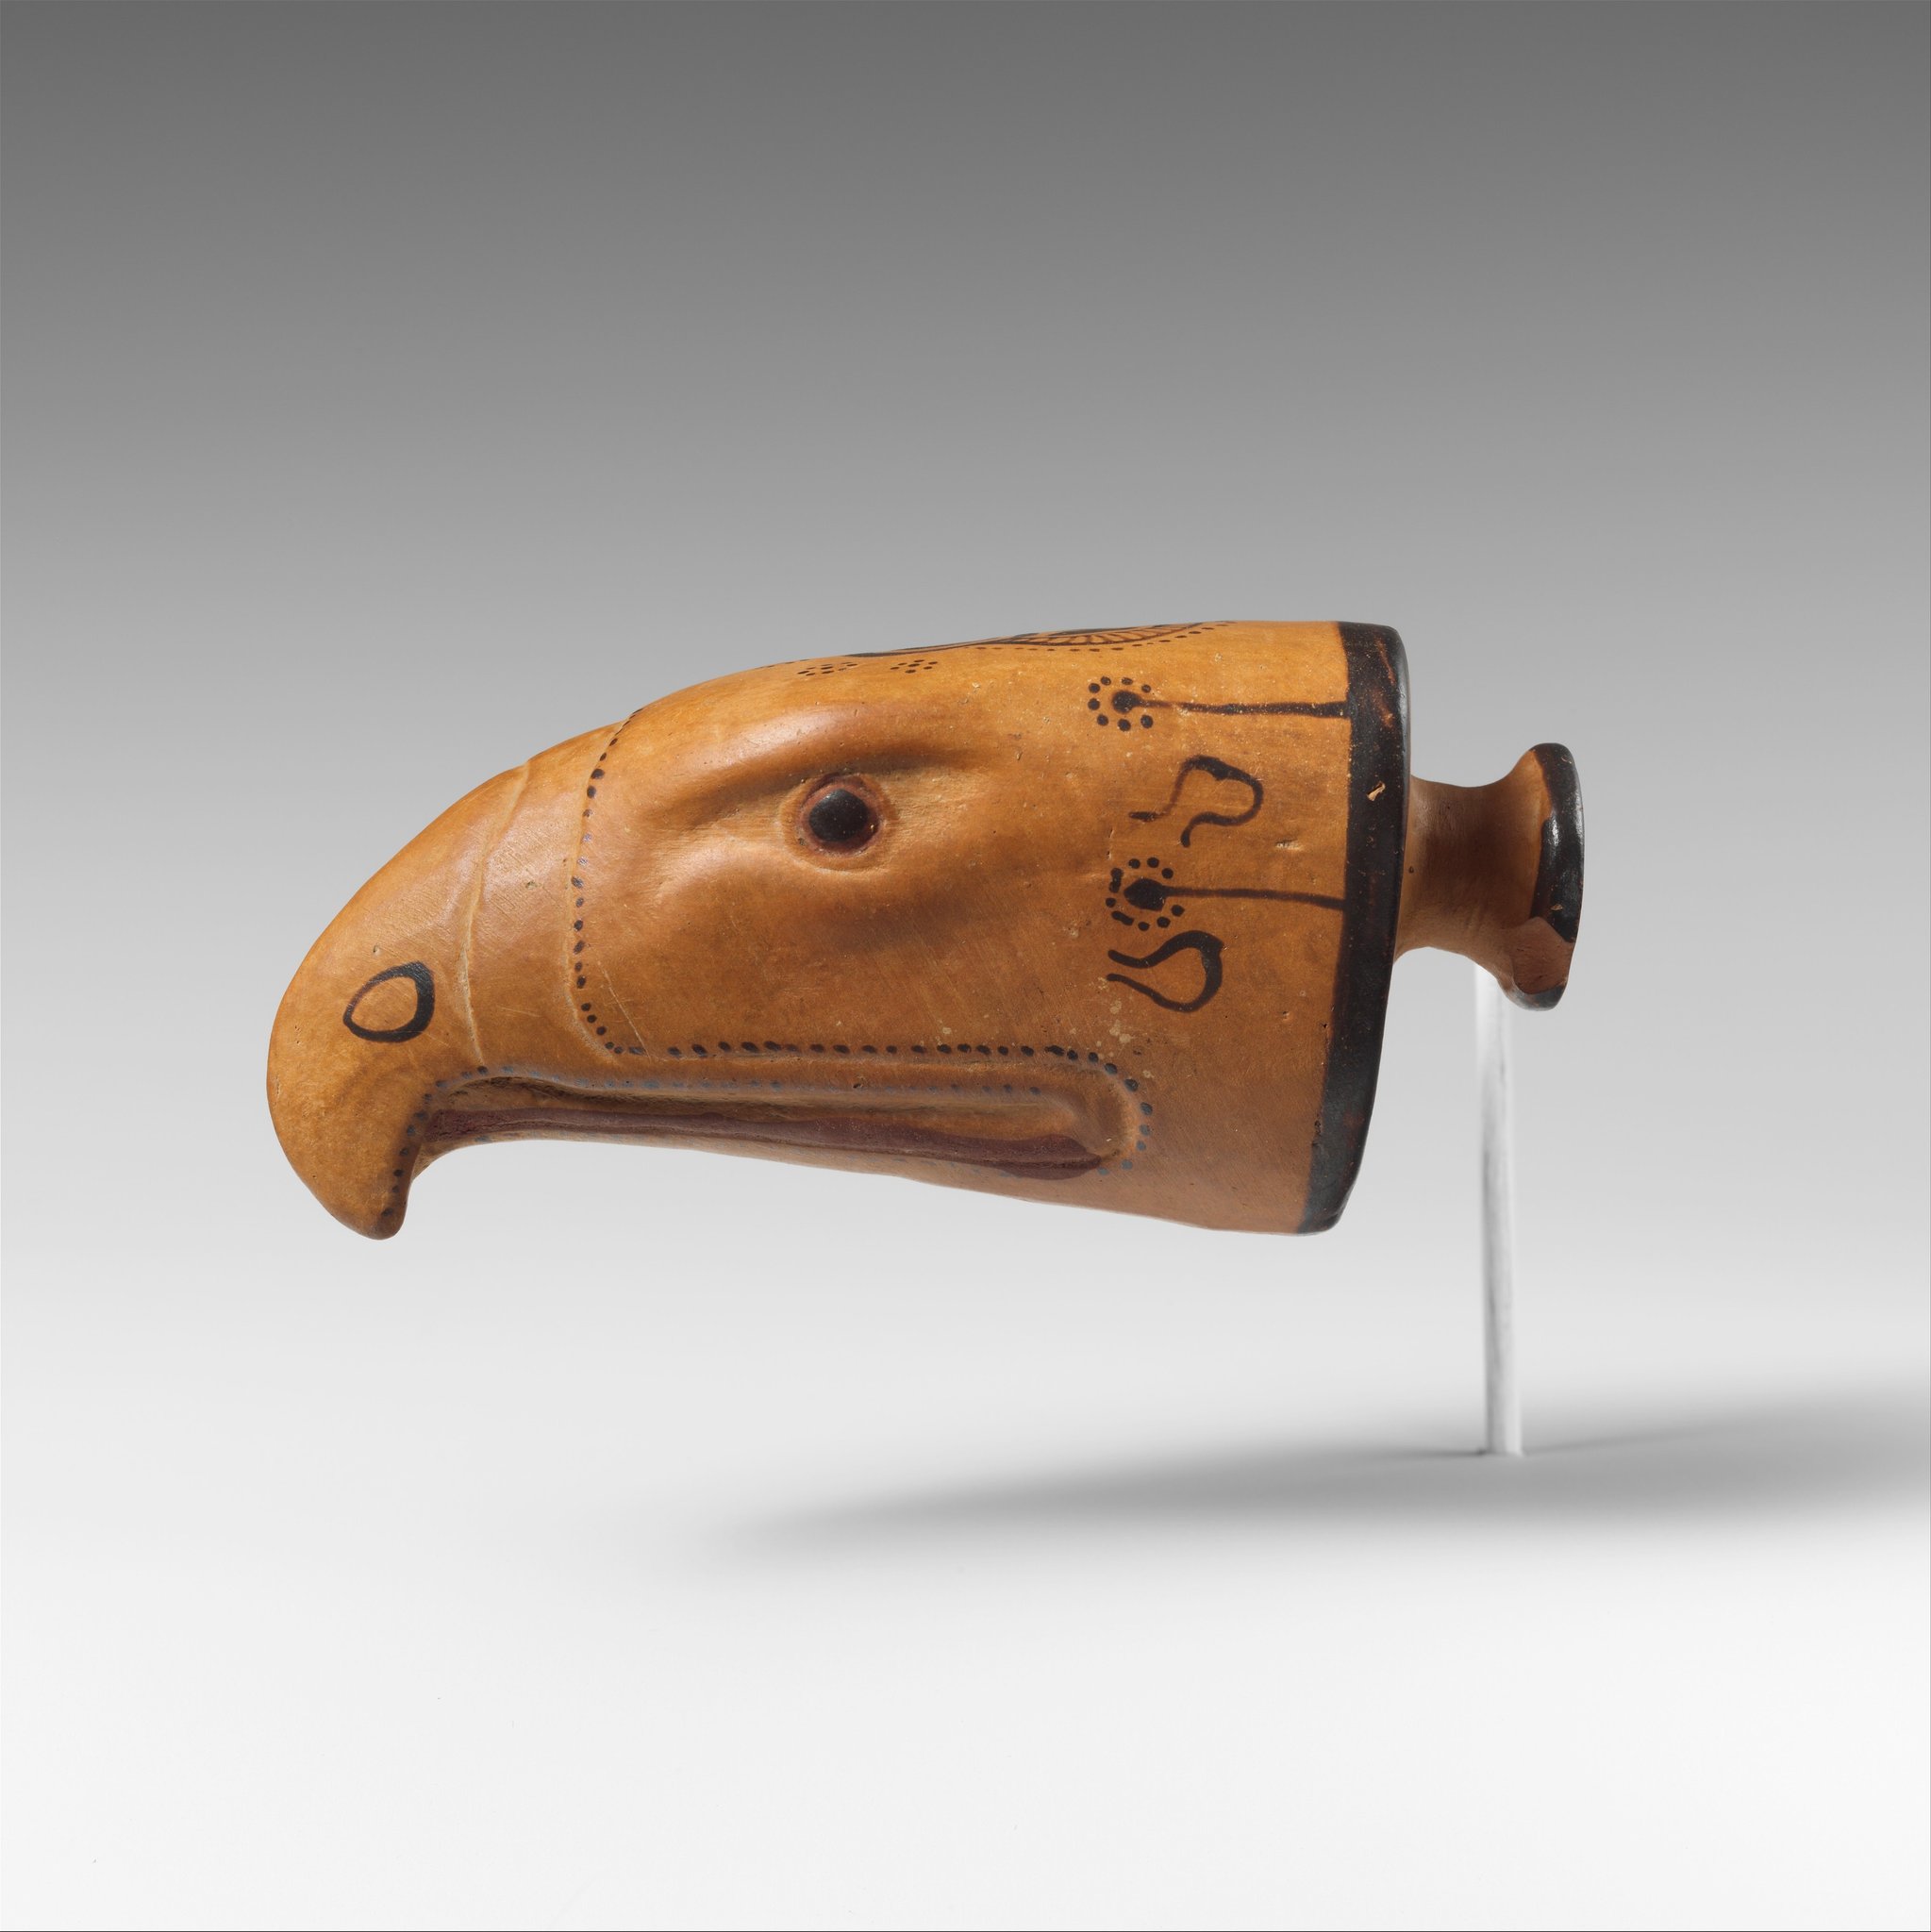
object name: aryballos in the form of an eagle's head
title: Terracotta aryballos in the form of an eagle's head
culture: greek, rhodian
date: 634-568 BCE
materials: terracotta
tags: eagles